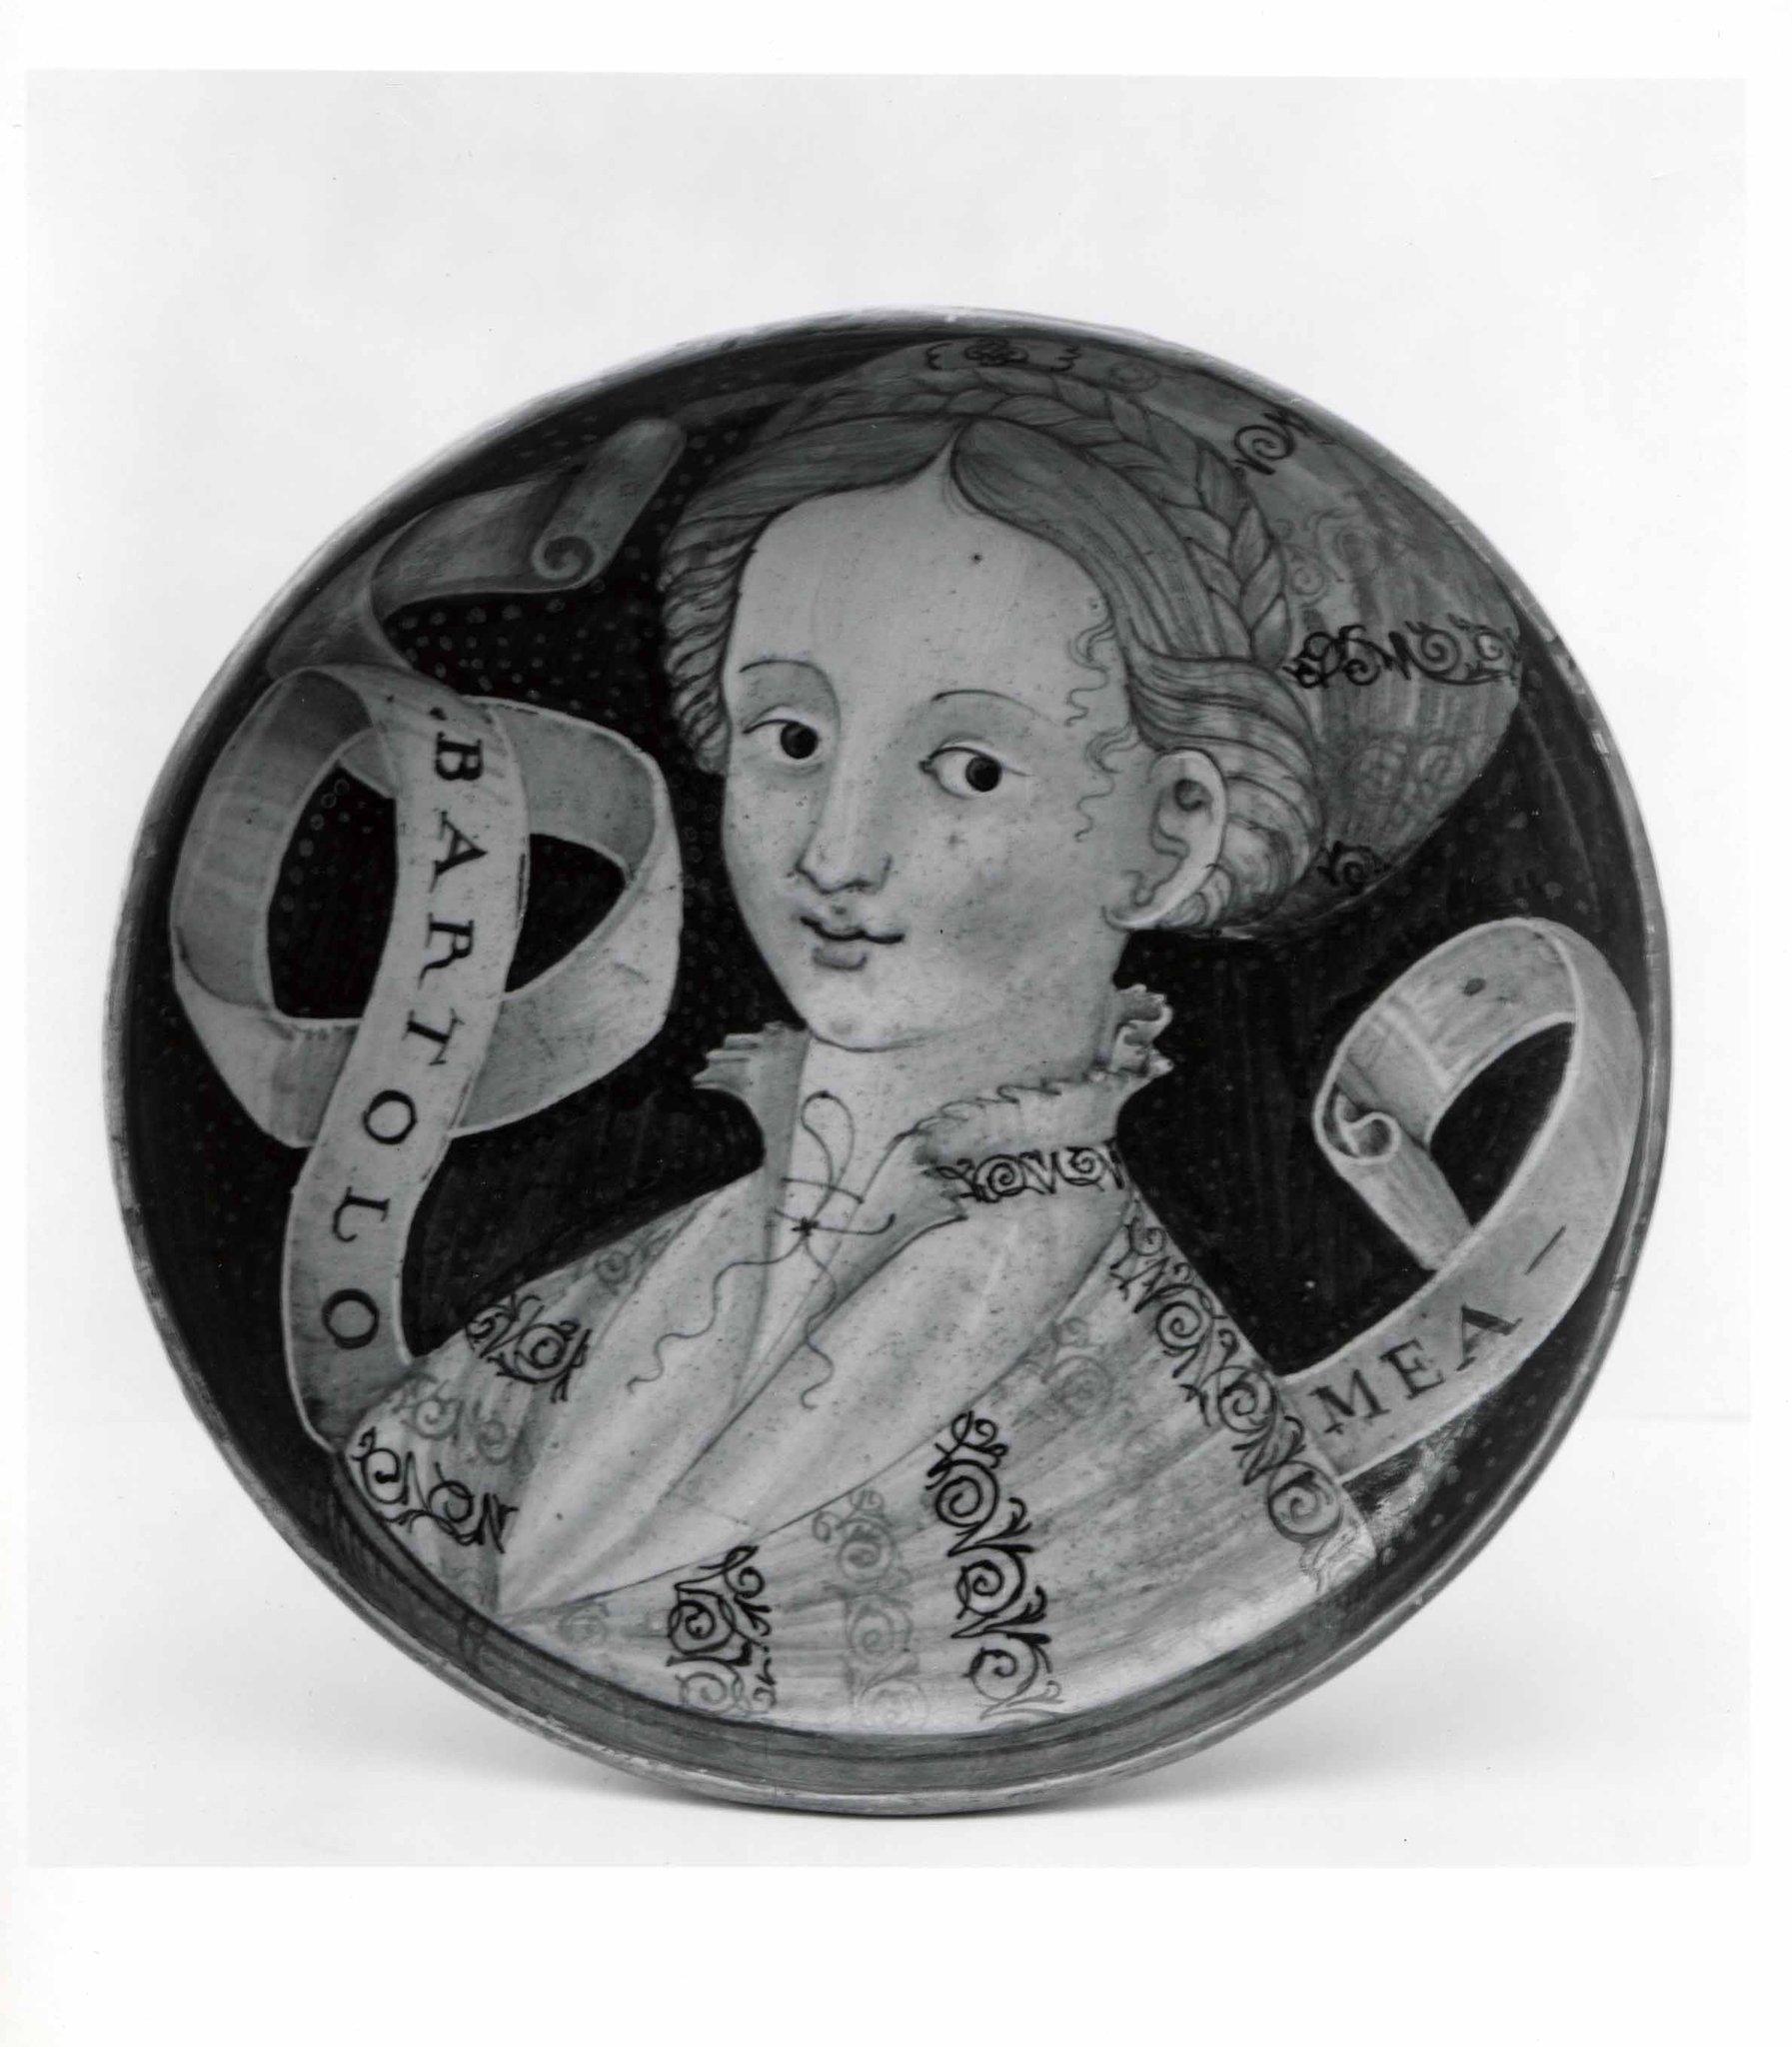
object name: dish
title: Dish (coppa)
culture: italian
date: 1535-1540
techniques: maiolica, glazing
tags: women